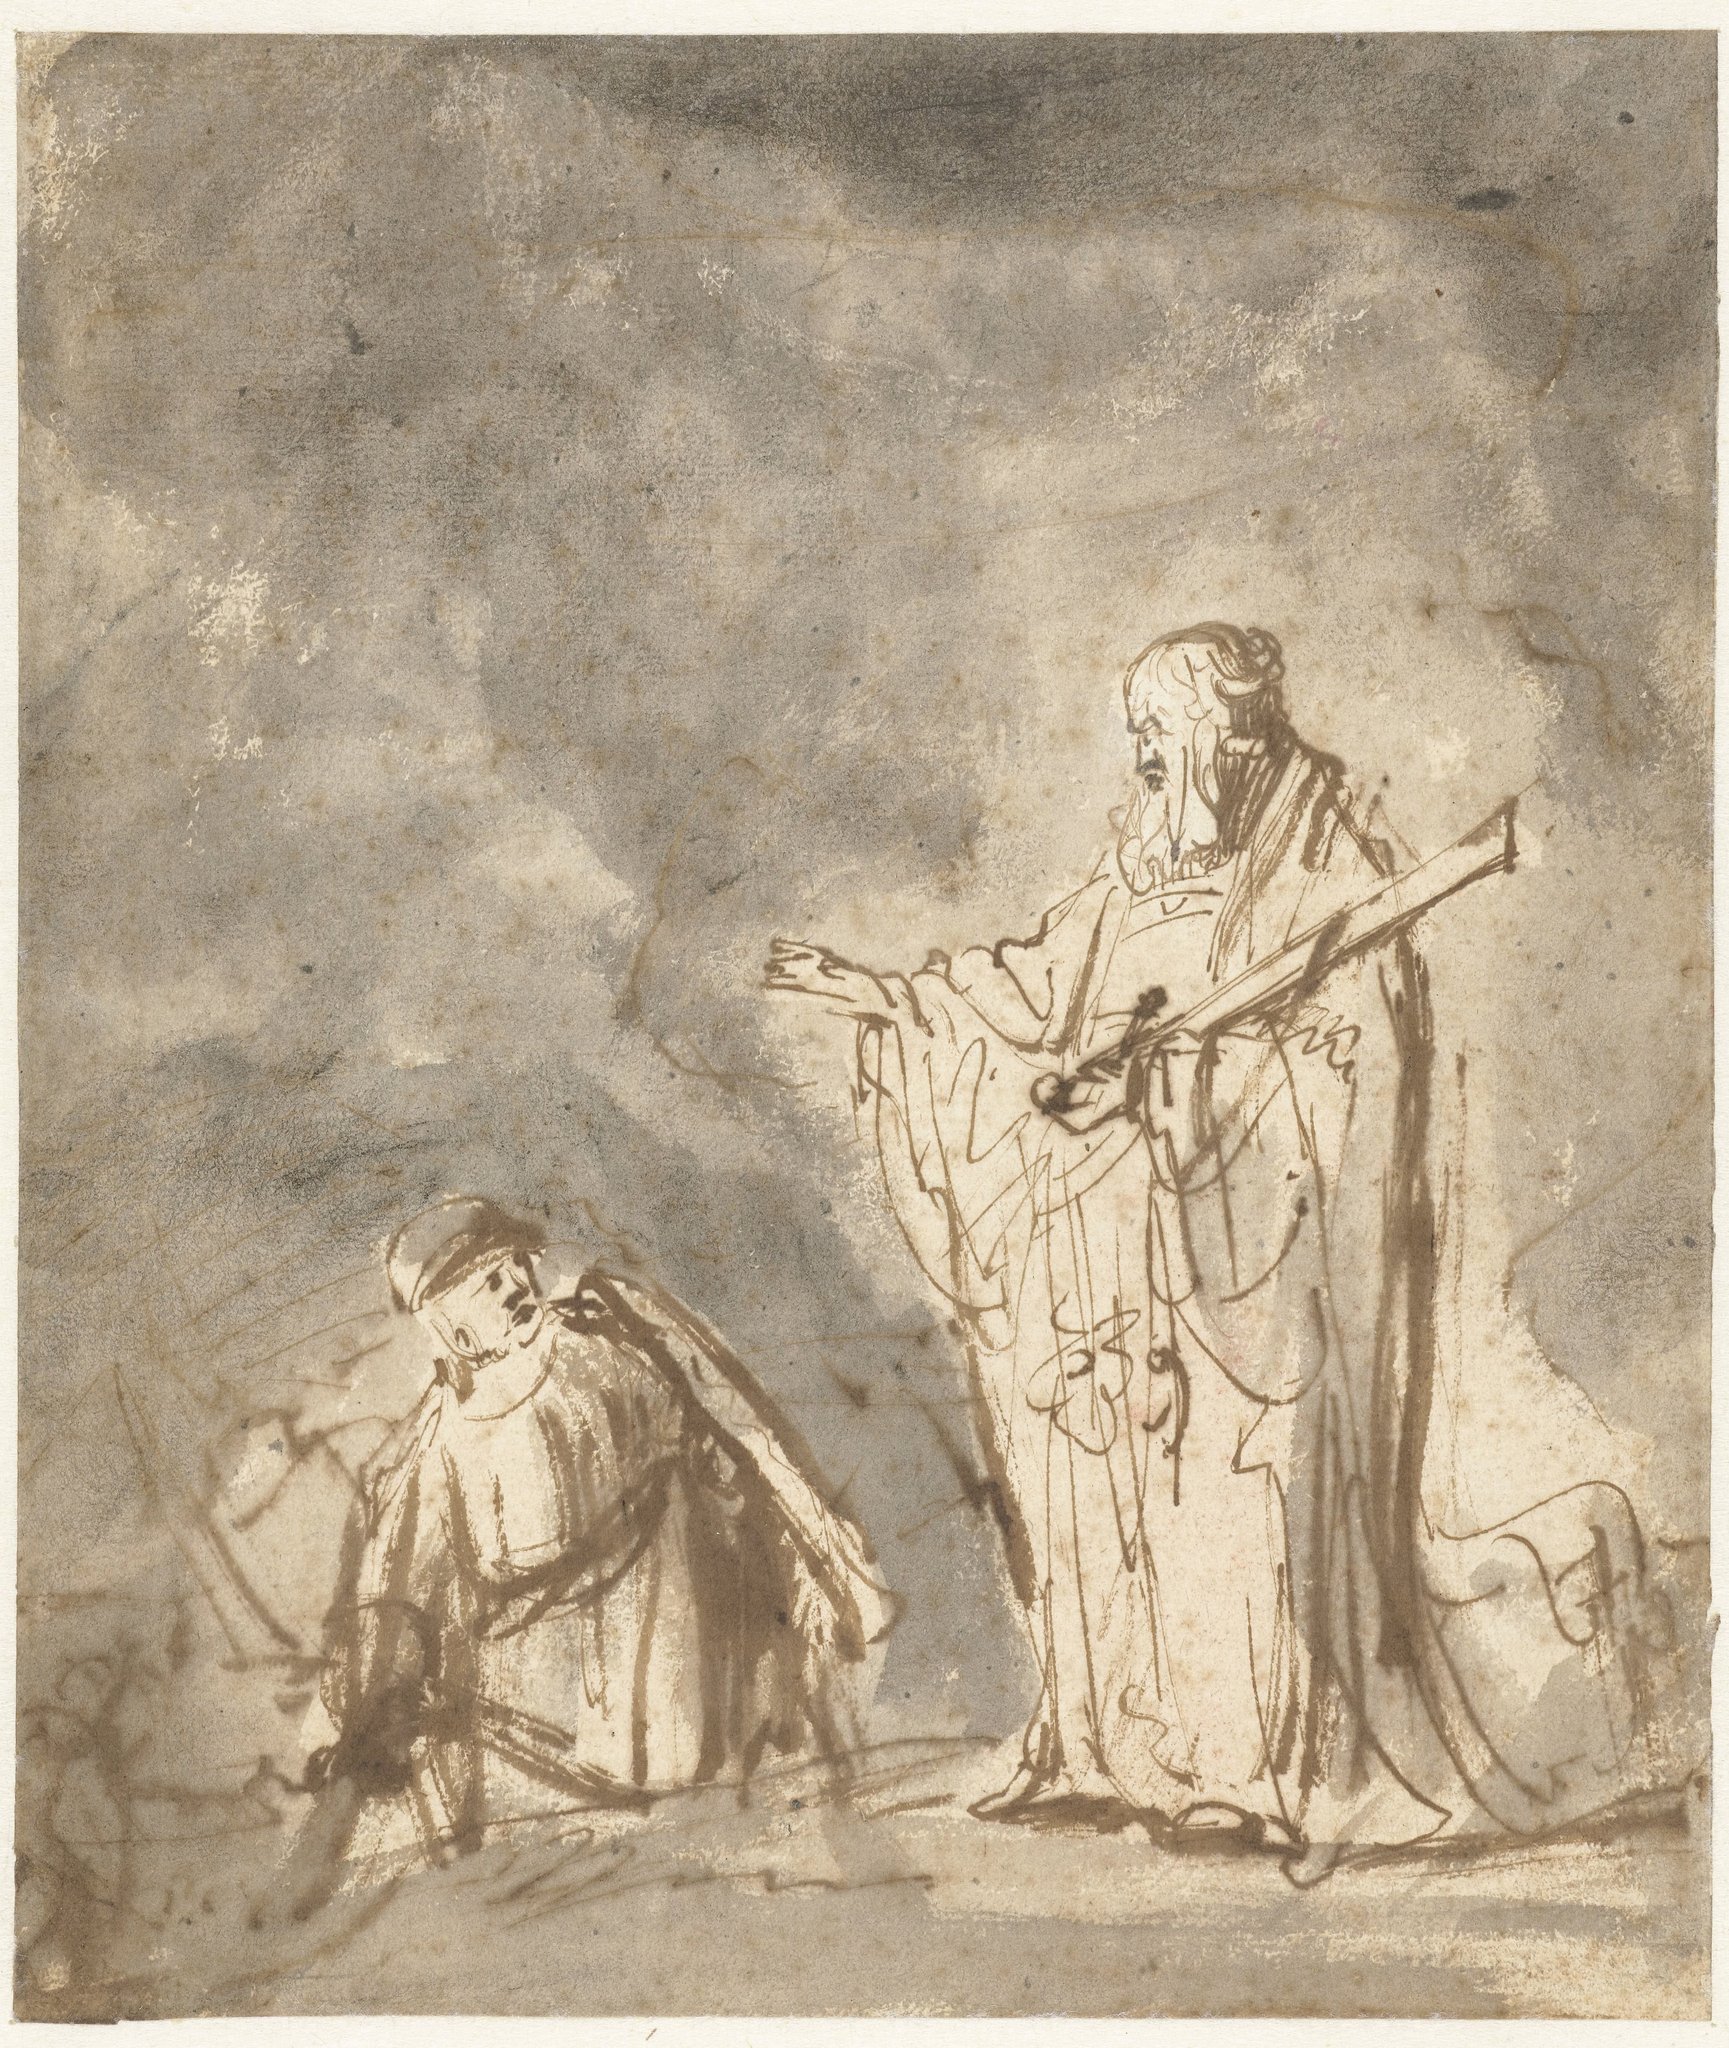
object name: drawing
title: De bode van God verschijnt aan Jozua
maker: ferdinand bol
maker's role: draughtsman, painter, print maker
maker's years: 1616-1680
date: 1640-1645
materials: ink, paper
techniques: brush, pen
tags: joshua encounters an angel holding a sword (at first not recognizing the angel, joshua may be shown drawing his sword)